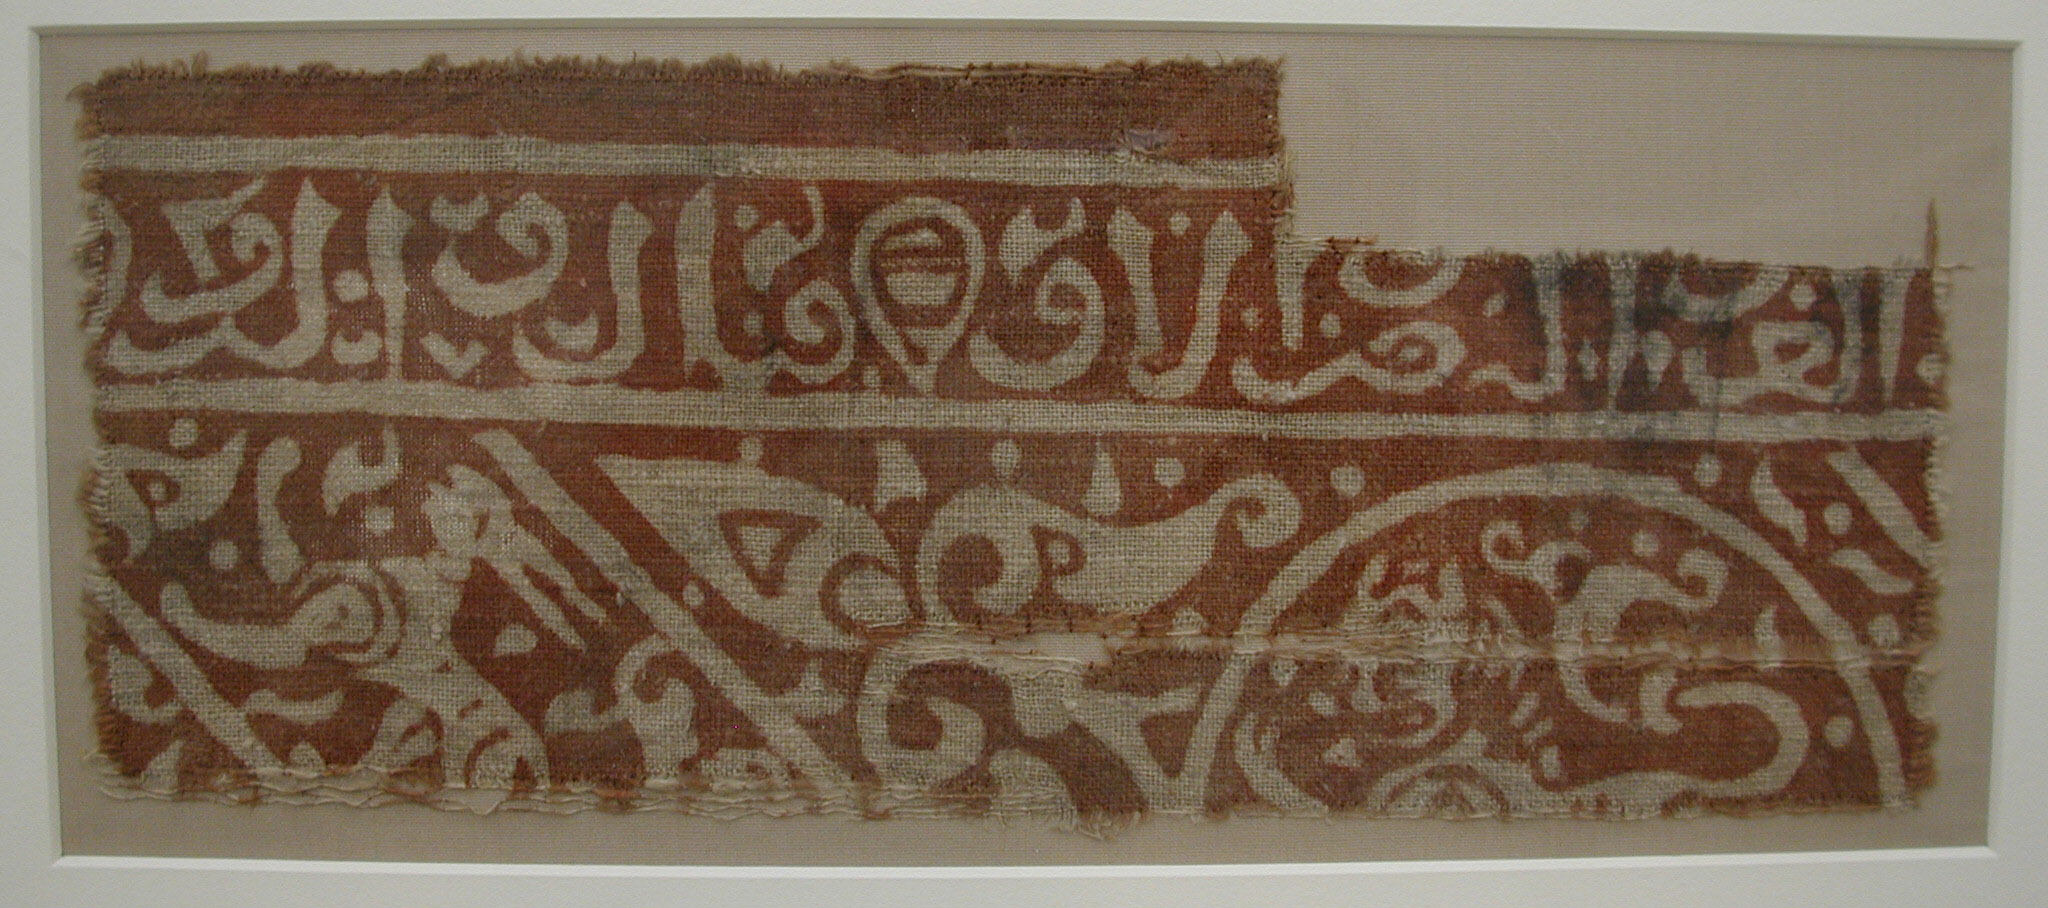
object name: textile fragment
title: Fragment of a Calligraphic Textile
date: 1267-1400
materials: cotton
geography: egypt